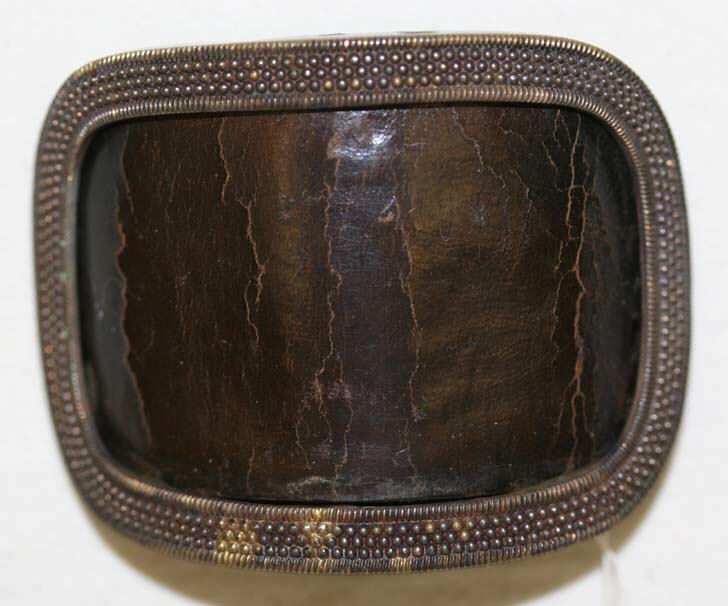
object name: shoe buckle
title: Shoe buckles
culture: french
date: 1800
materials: leather, metal